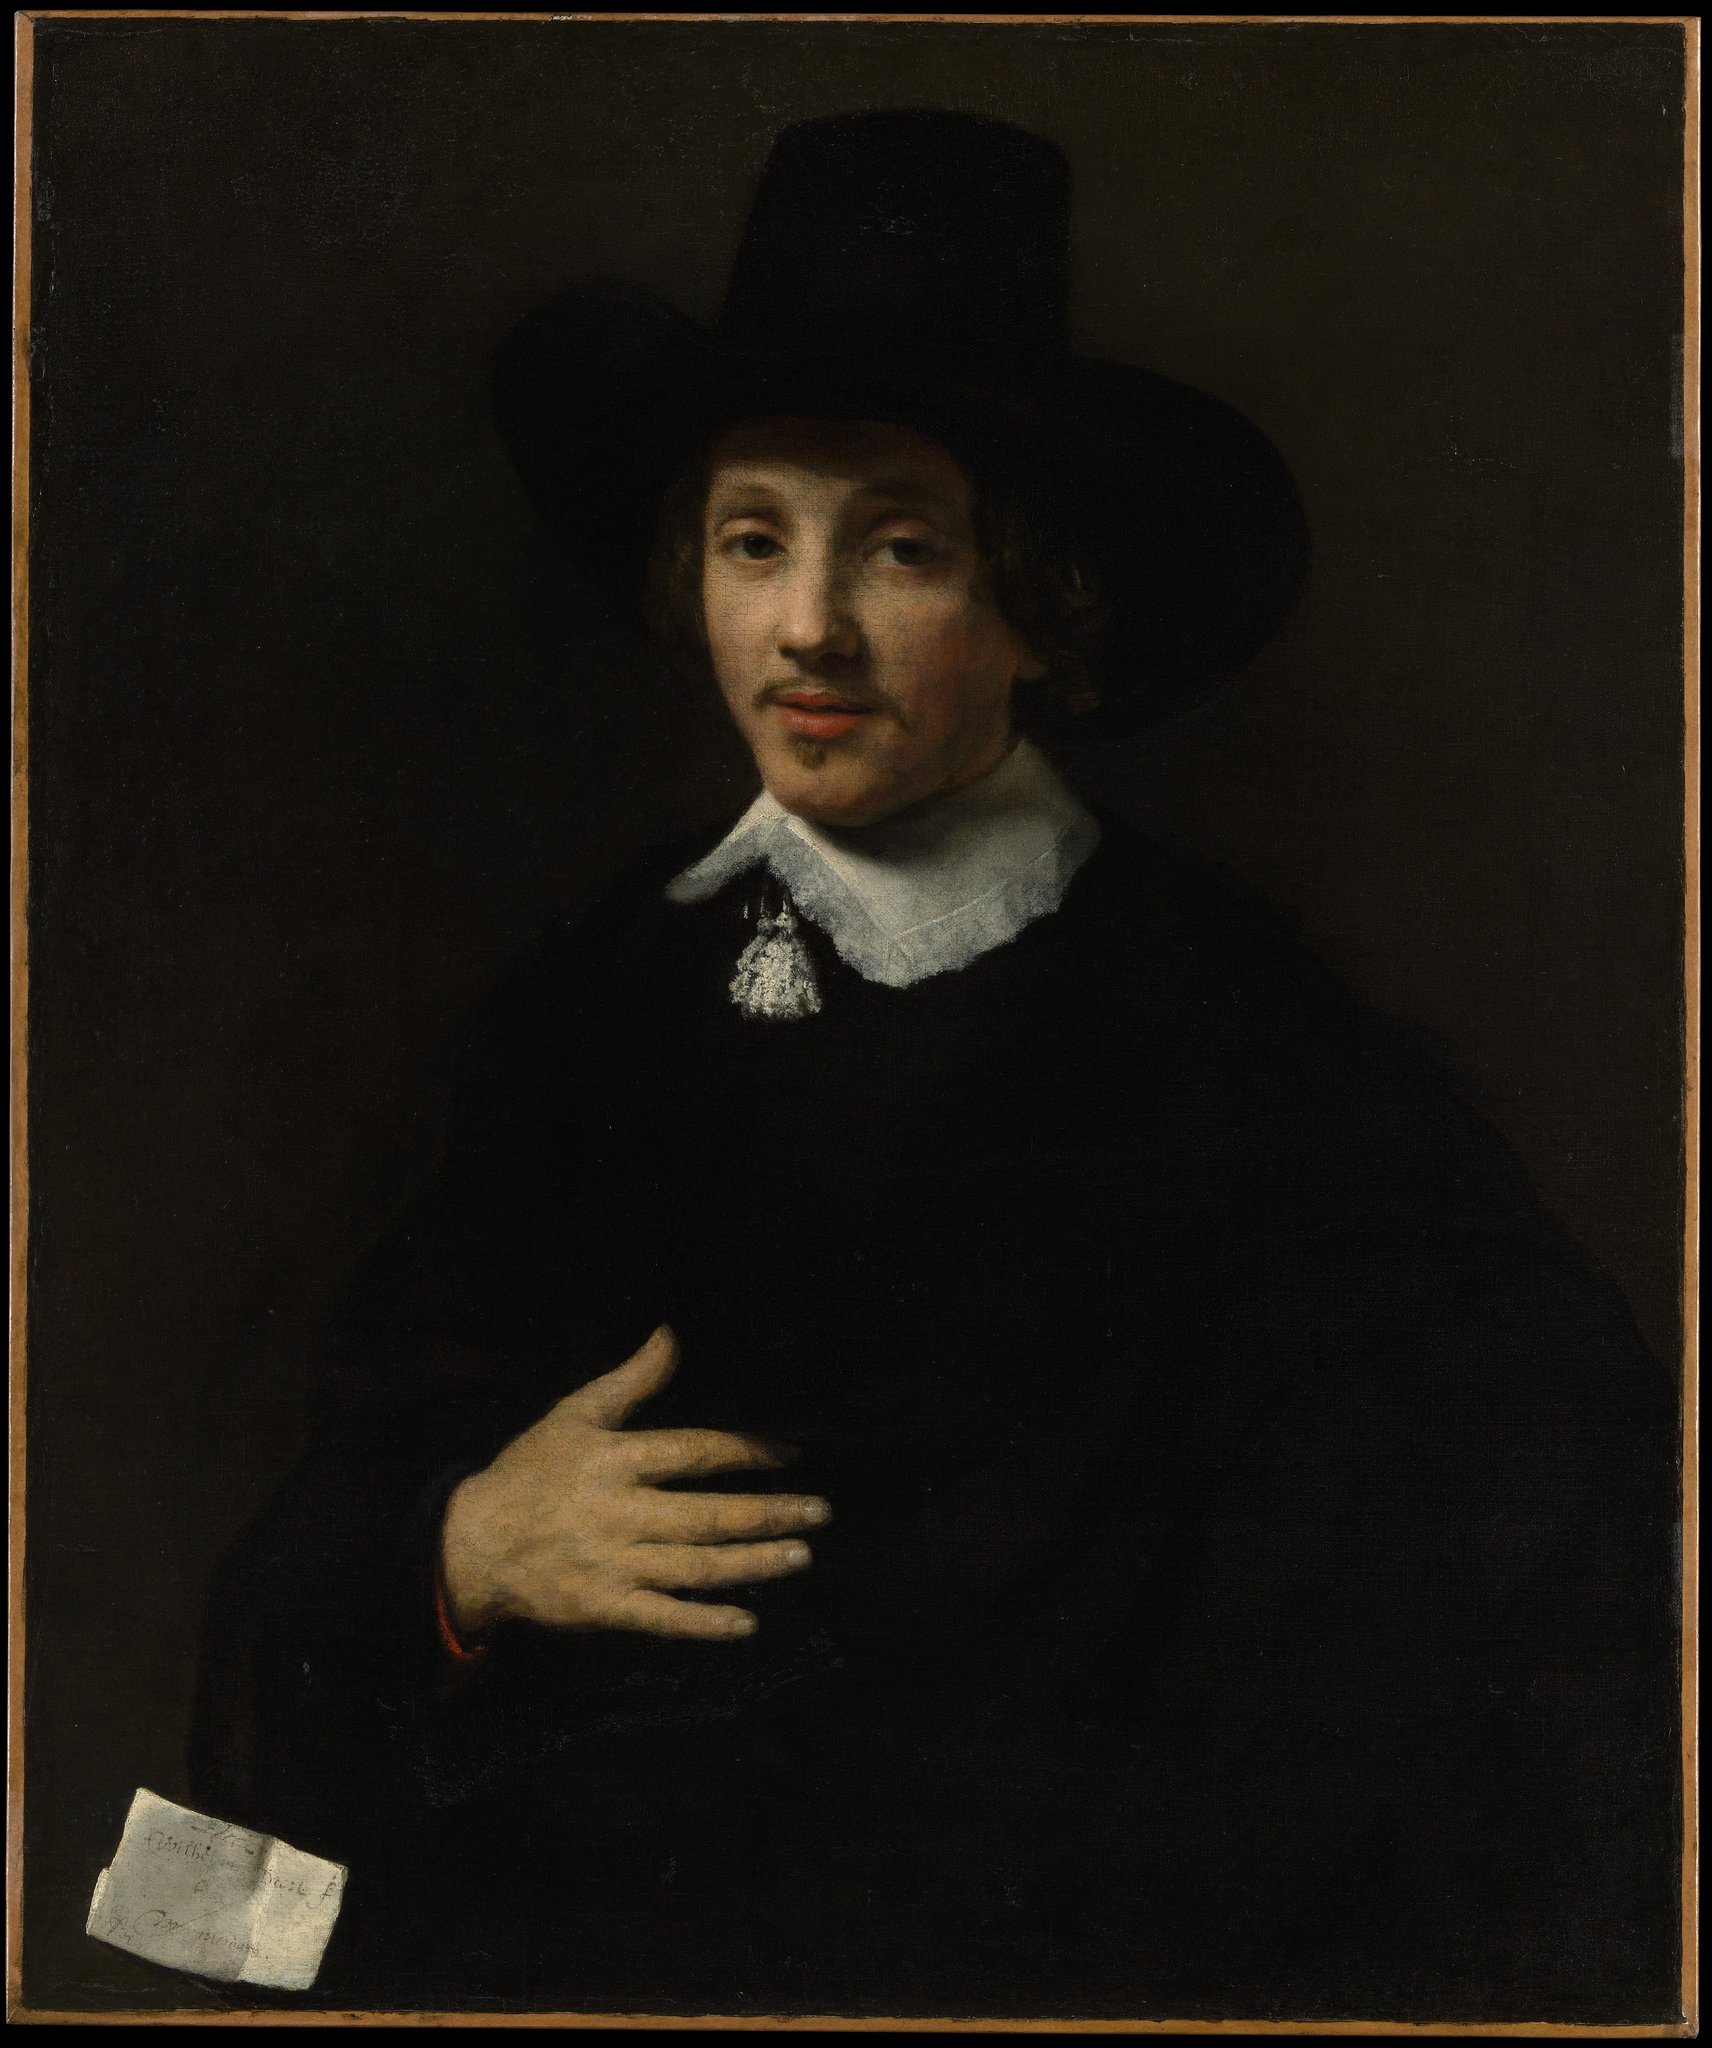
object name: painting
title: Portrait of a Man (Self-Portrait?)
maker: willem drost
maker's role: artist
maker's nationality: dutch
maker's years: 1633-1659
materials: canvas, oil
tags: men,portraits